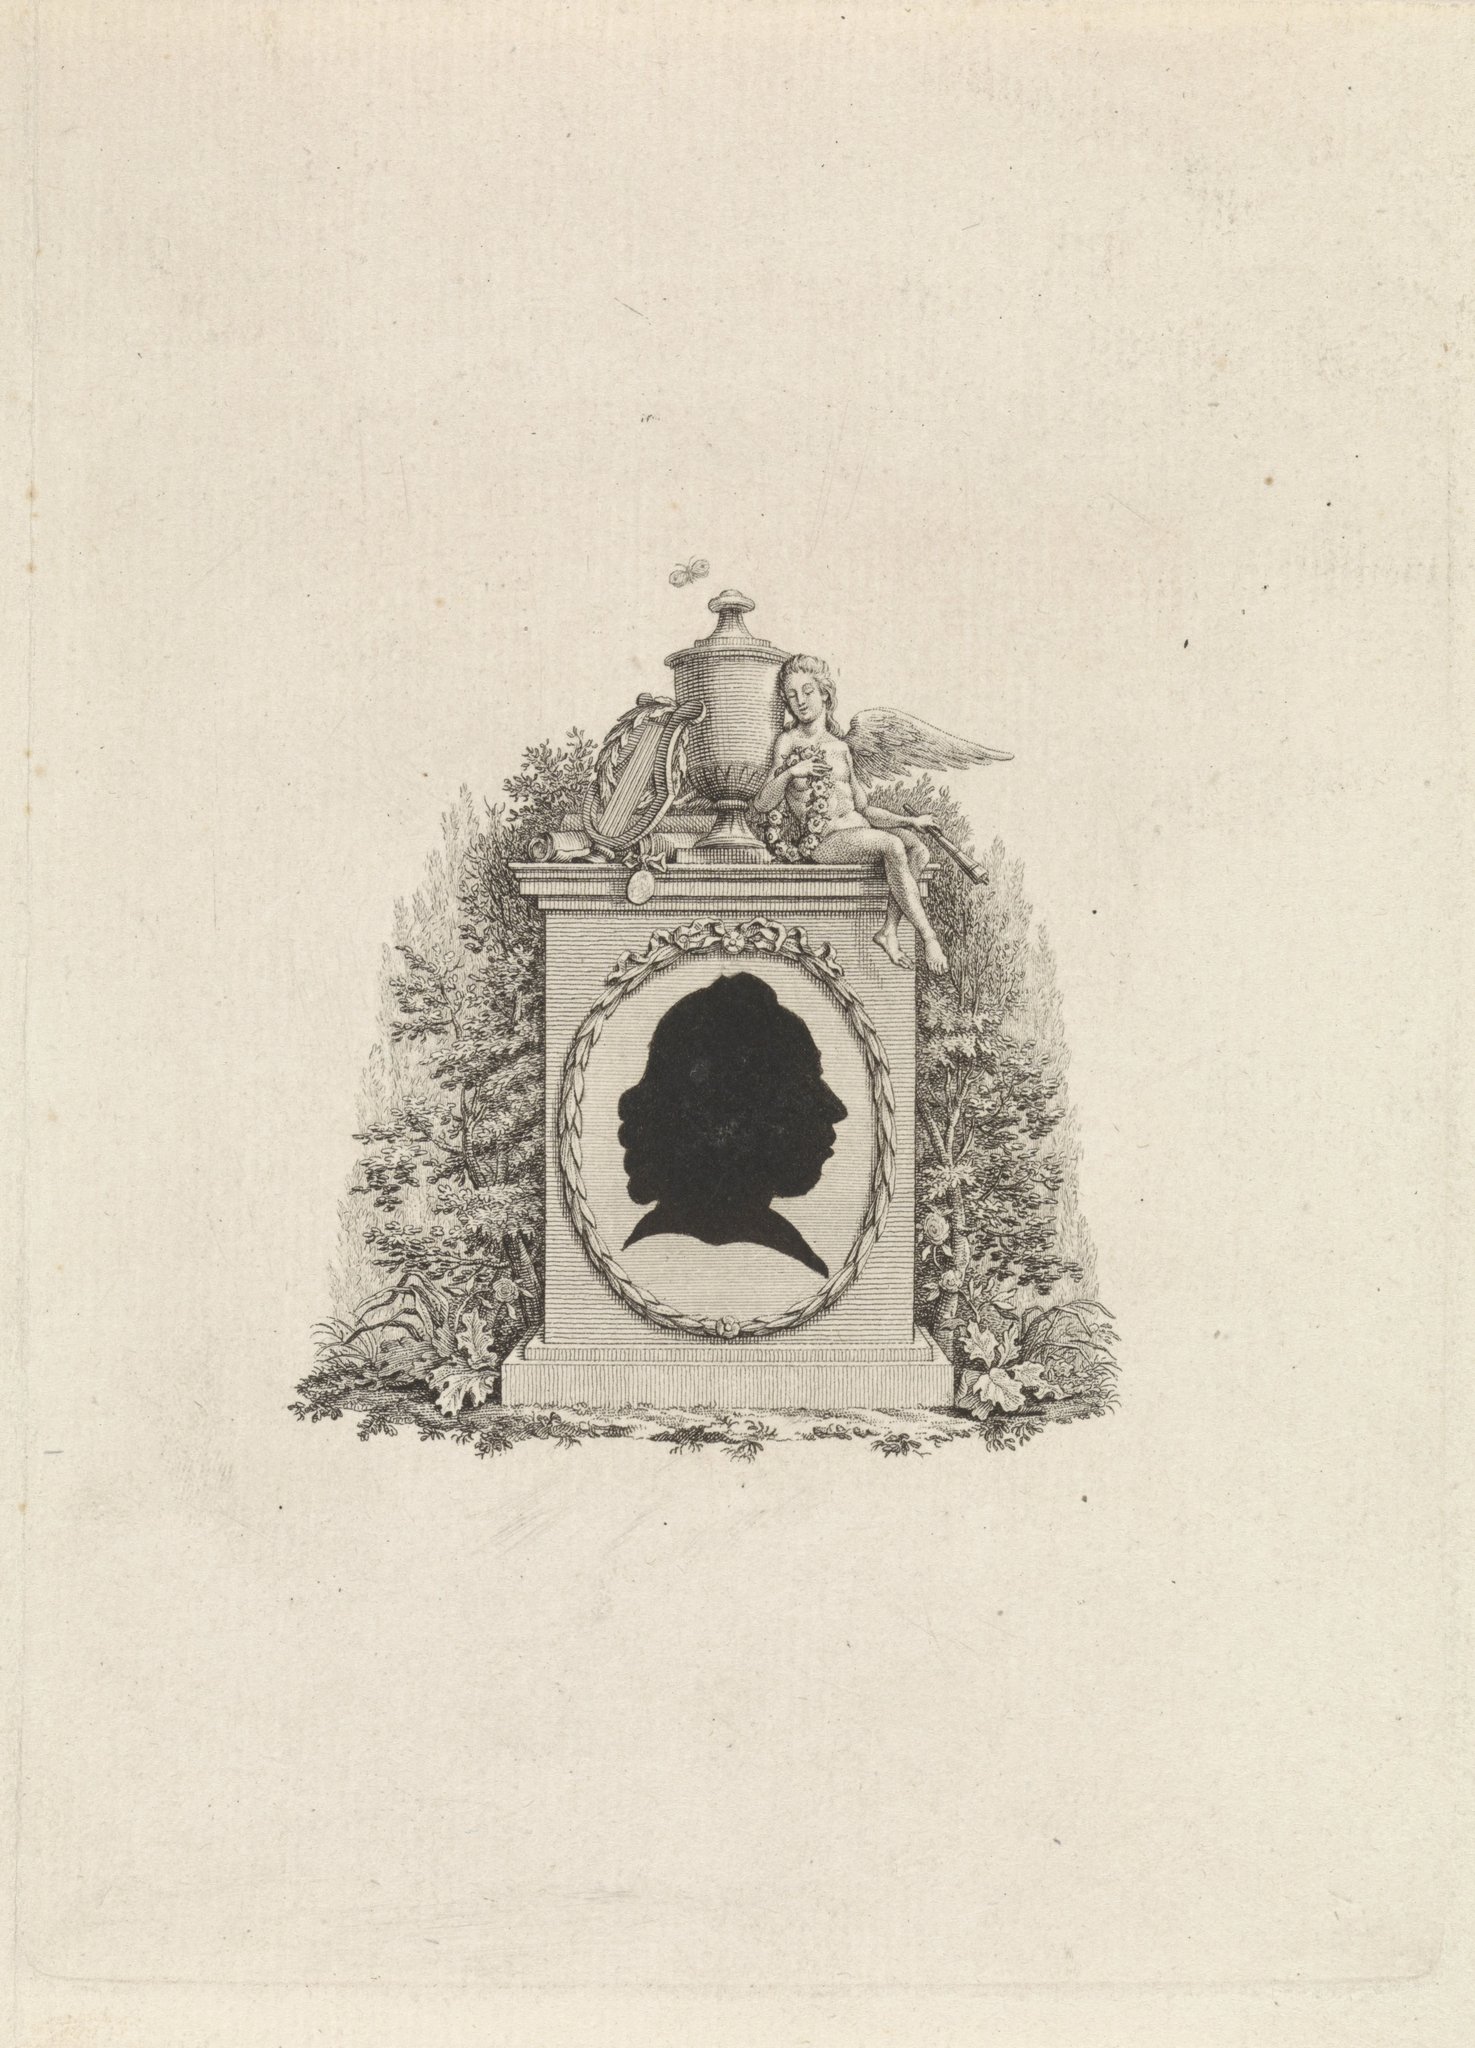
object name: print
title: Gedenkteken voor Johannes Christiaan Mohr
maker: theodoor koning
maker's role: print maker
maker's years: 1748-1829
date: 1787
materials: paper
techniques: etching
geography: amsterdam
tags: amsterdam, johannes christiaan mohr, other memorial structures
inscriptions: collector's mark: Lugt 2228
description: Allegorisch gedenkteken voor de dichter Johannes Christiaan Mohr. In het midden het monument met daarop het silhouetportret van Mohr, in een ovale omlijsting naar rechts. Op het monument een harp, bokaal, lauwerkrans, enkele brieven, medailles en een engeltje.